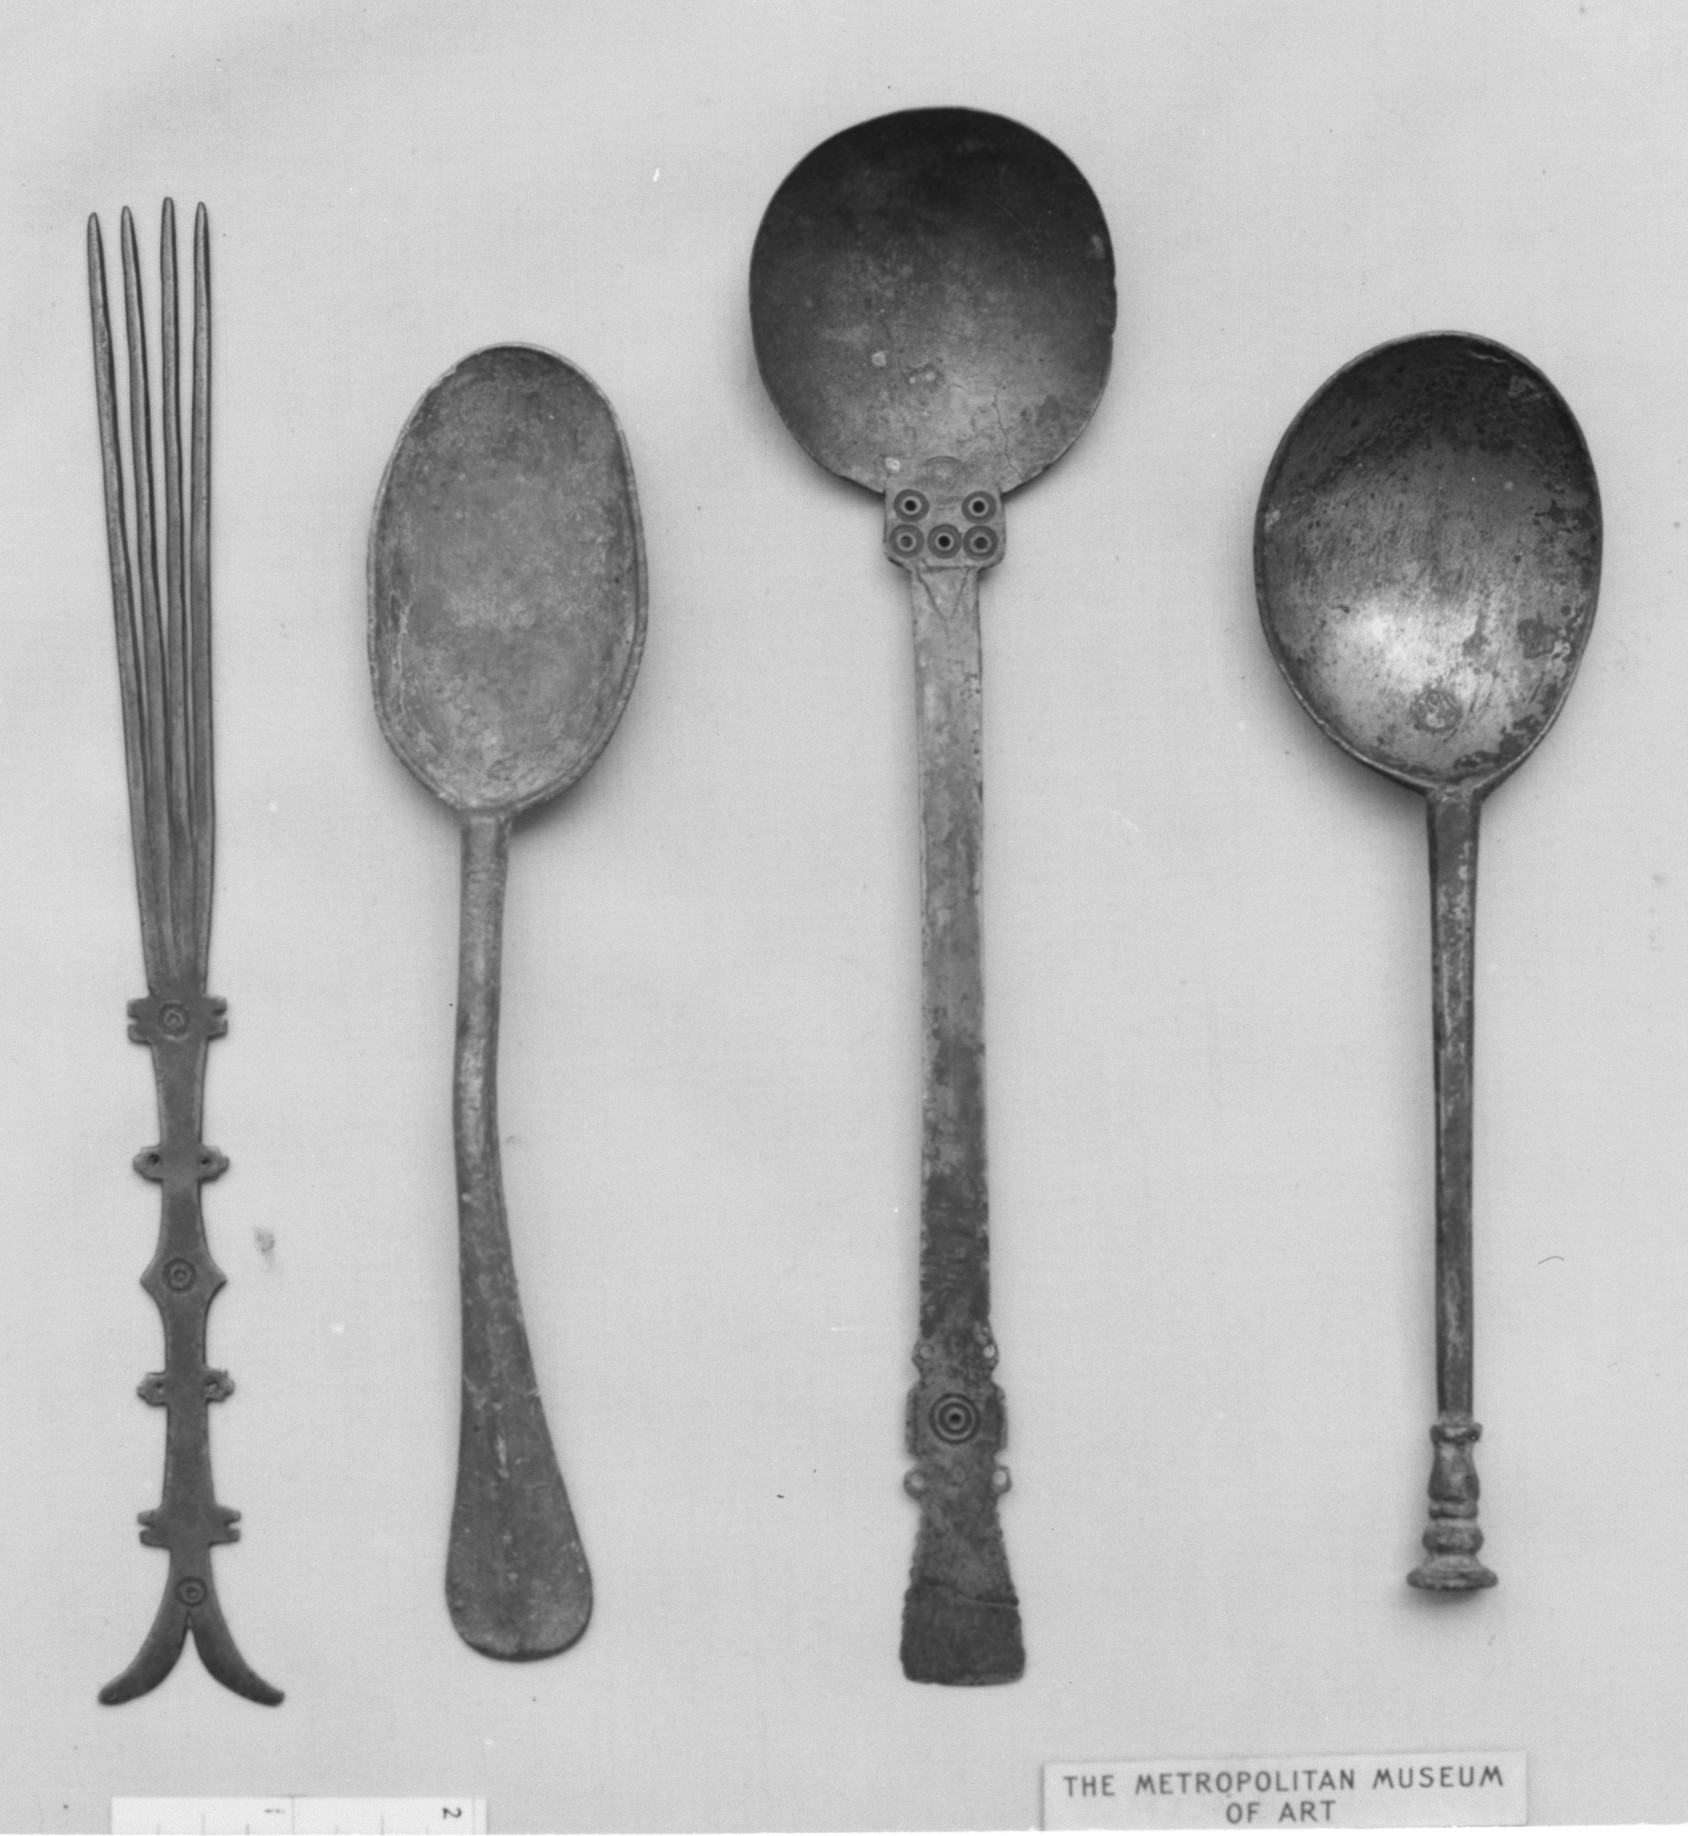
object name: spoon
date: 1601-1700